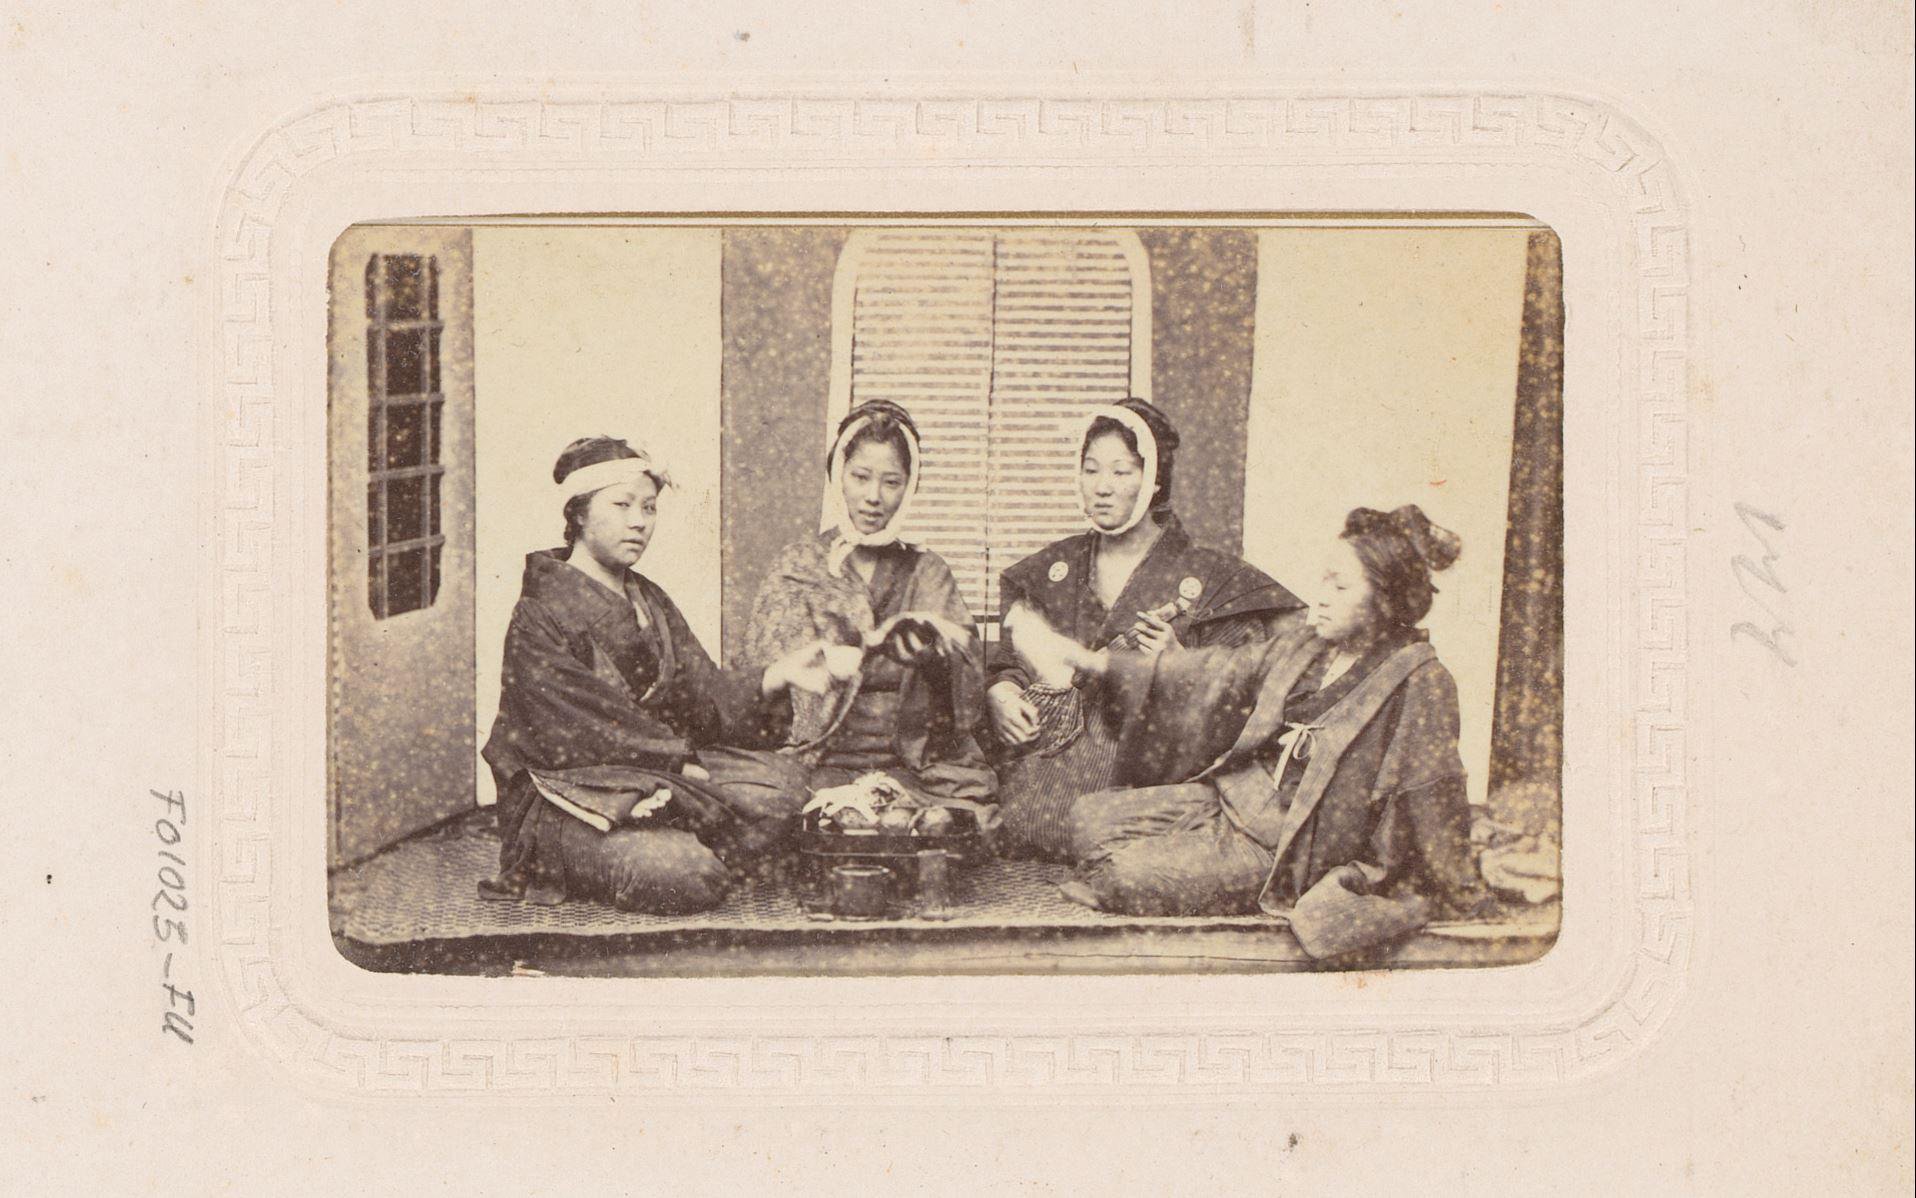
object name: photograph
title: Vier Japanse vrouwen drinken thee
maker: Anonymous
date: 1850-1880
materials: cardboard, photographic support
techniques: albumen print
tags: adult woman, anonymous historical persons portrayed in a group, in a group-portrait - bb - woman, tea-ceremony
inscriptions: number: ‘177’